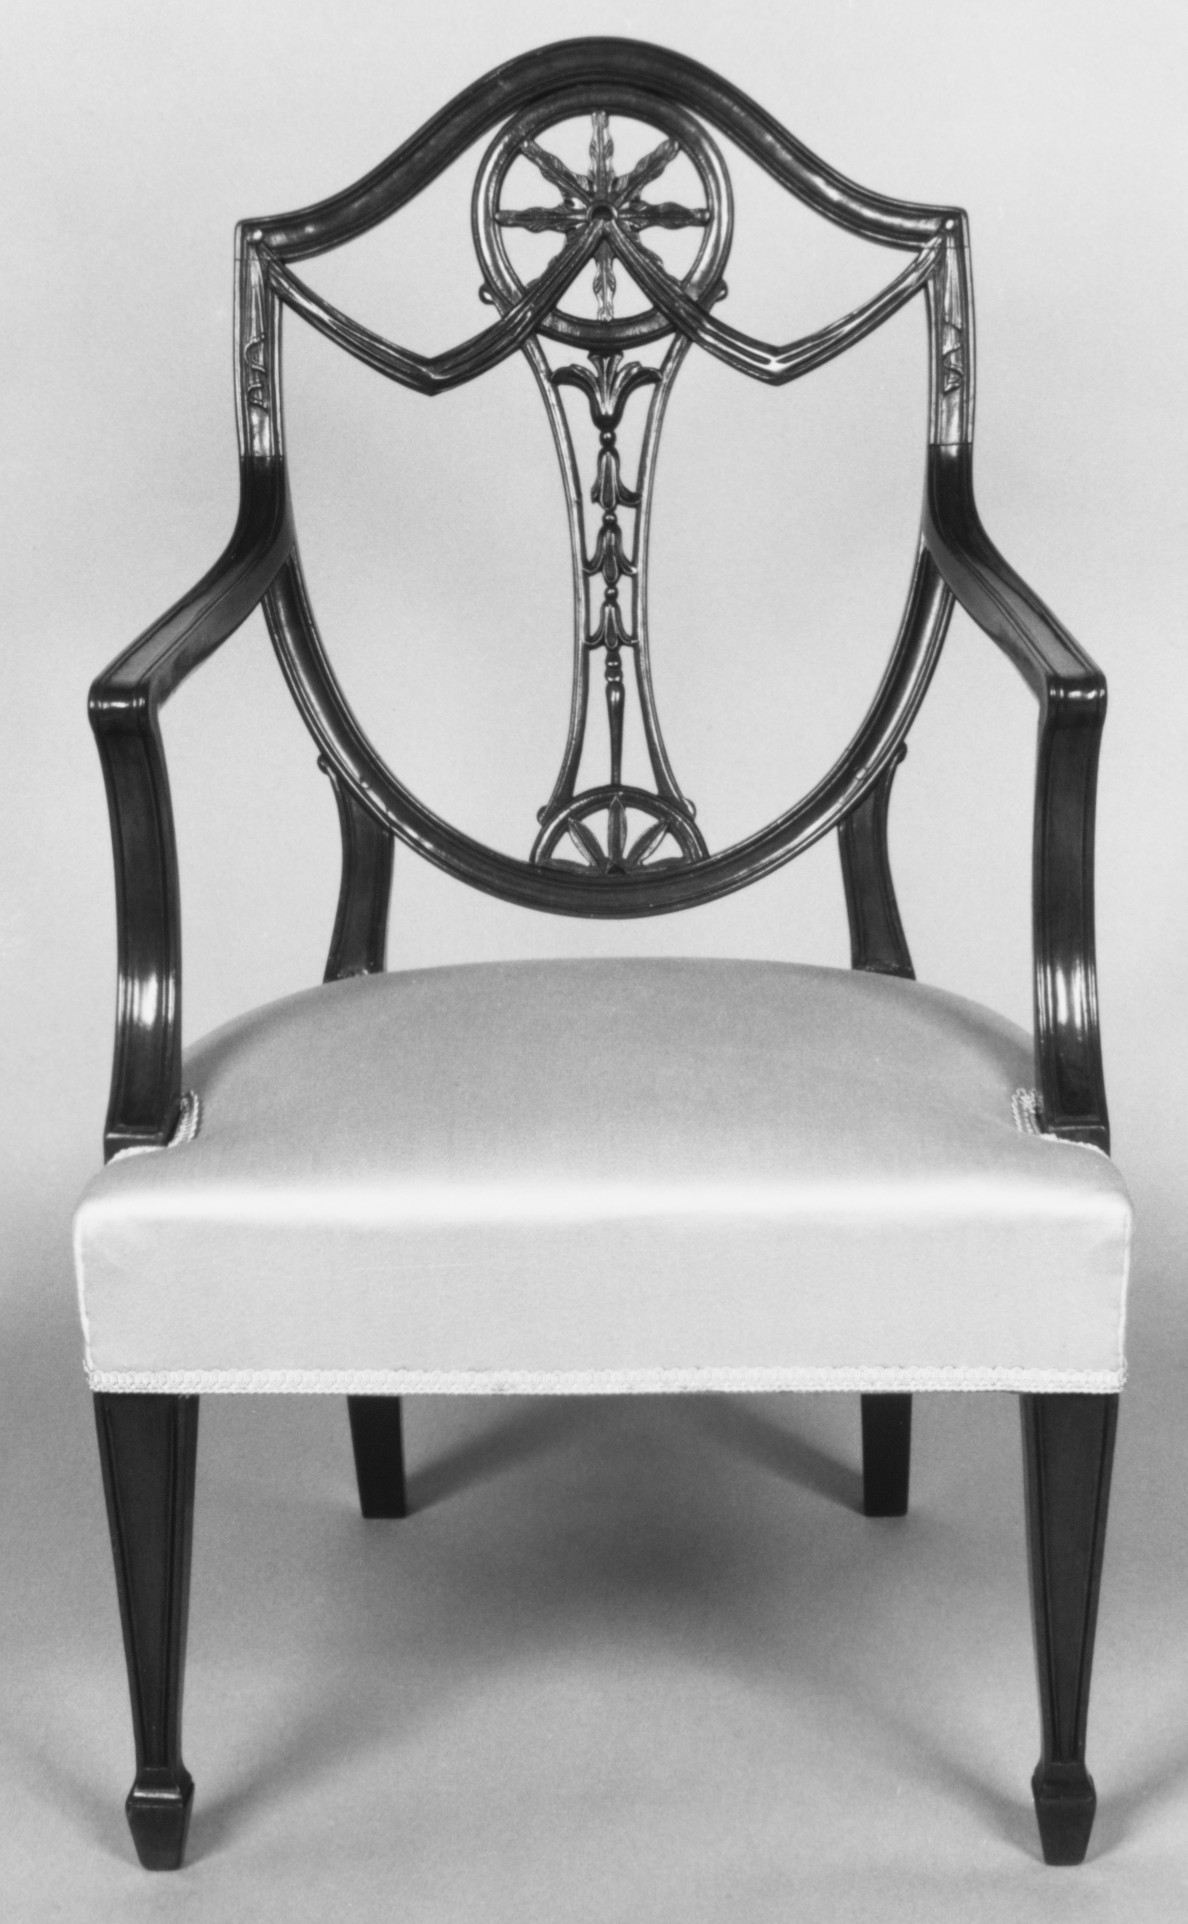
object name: armchair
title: Miniature armchair (part of a set)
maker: pierre-eloi langlois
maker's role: maker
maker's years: 1738-1805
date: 1795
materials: wood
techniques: veneering